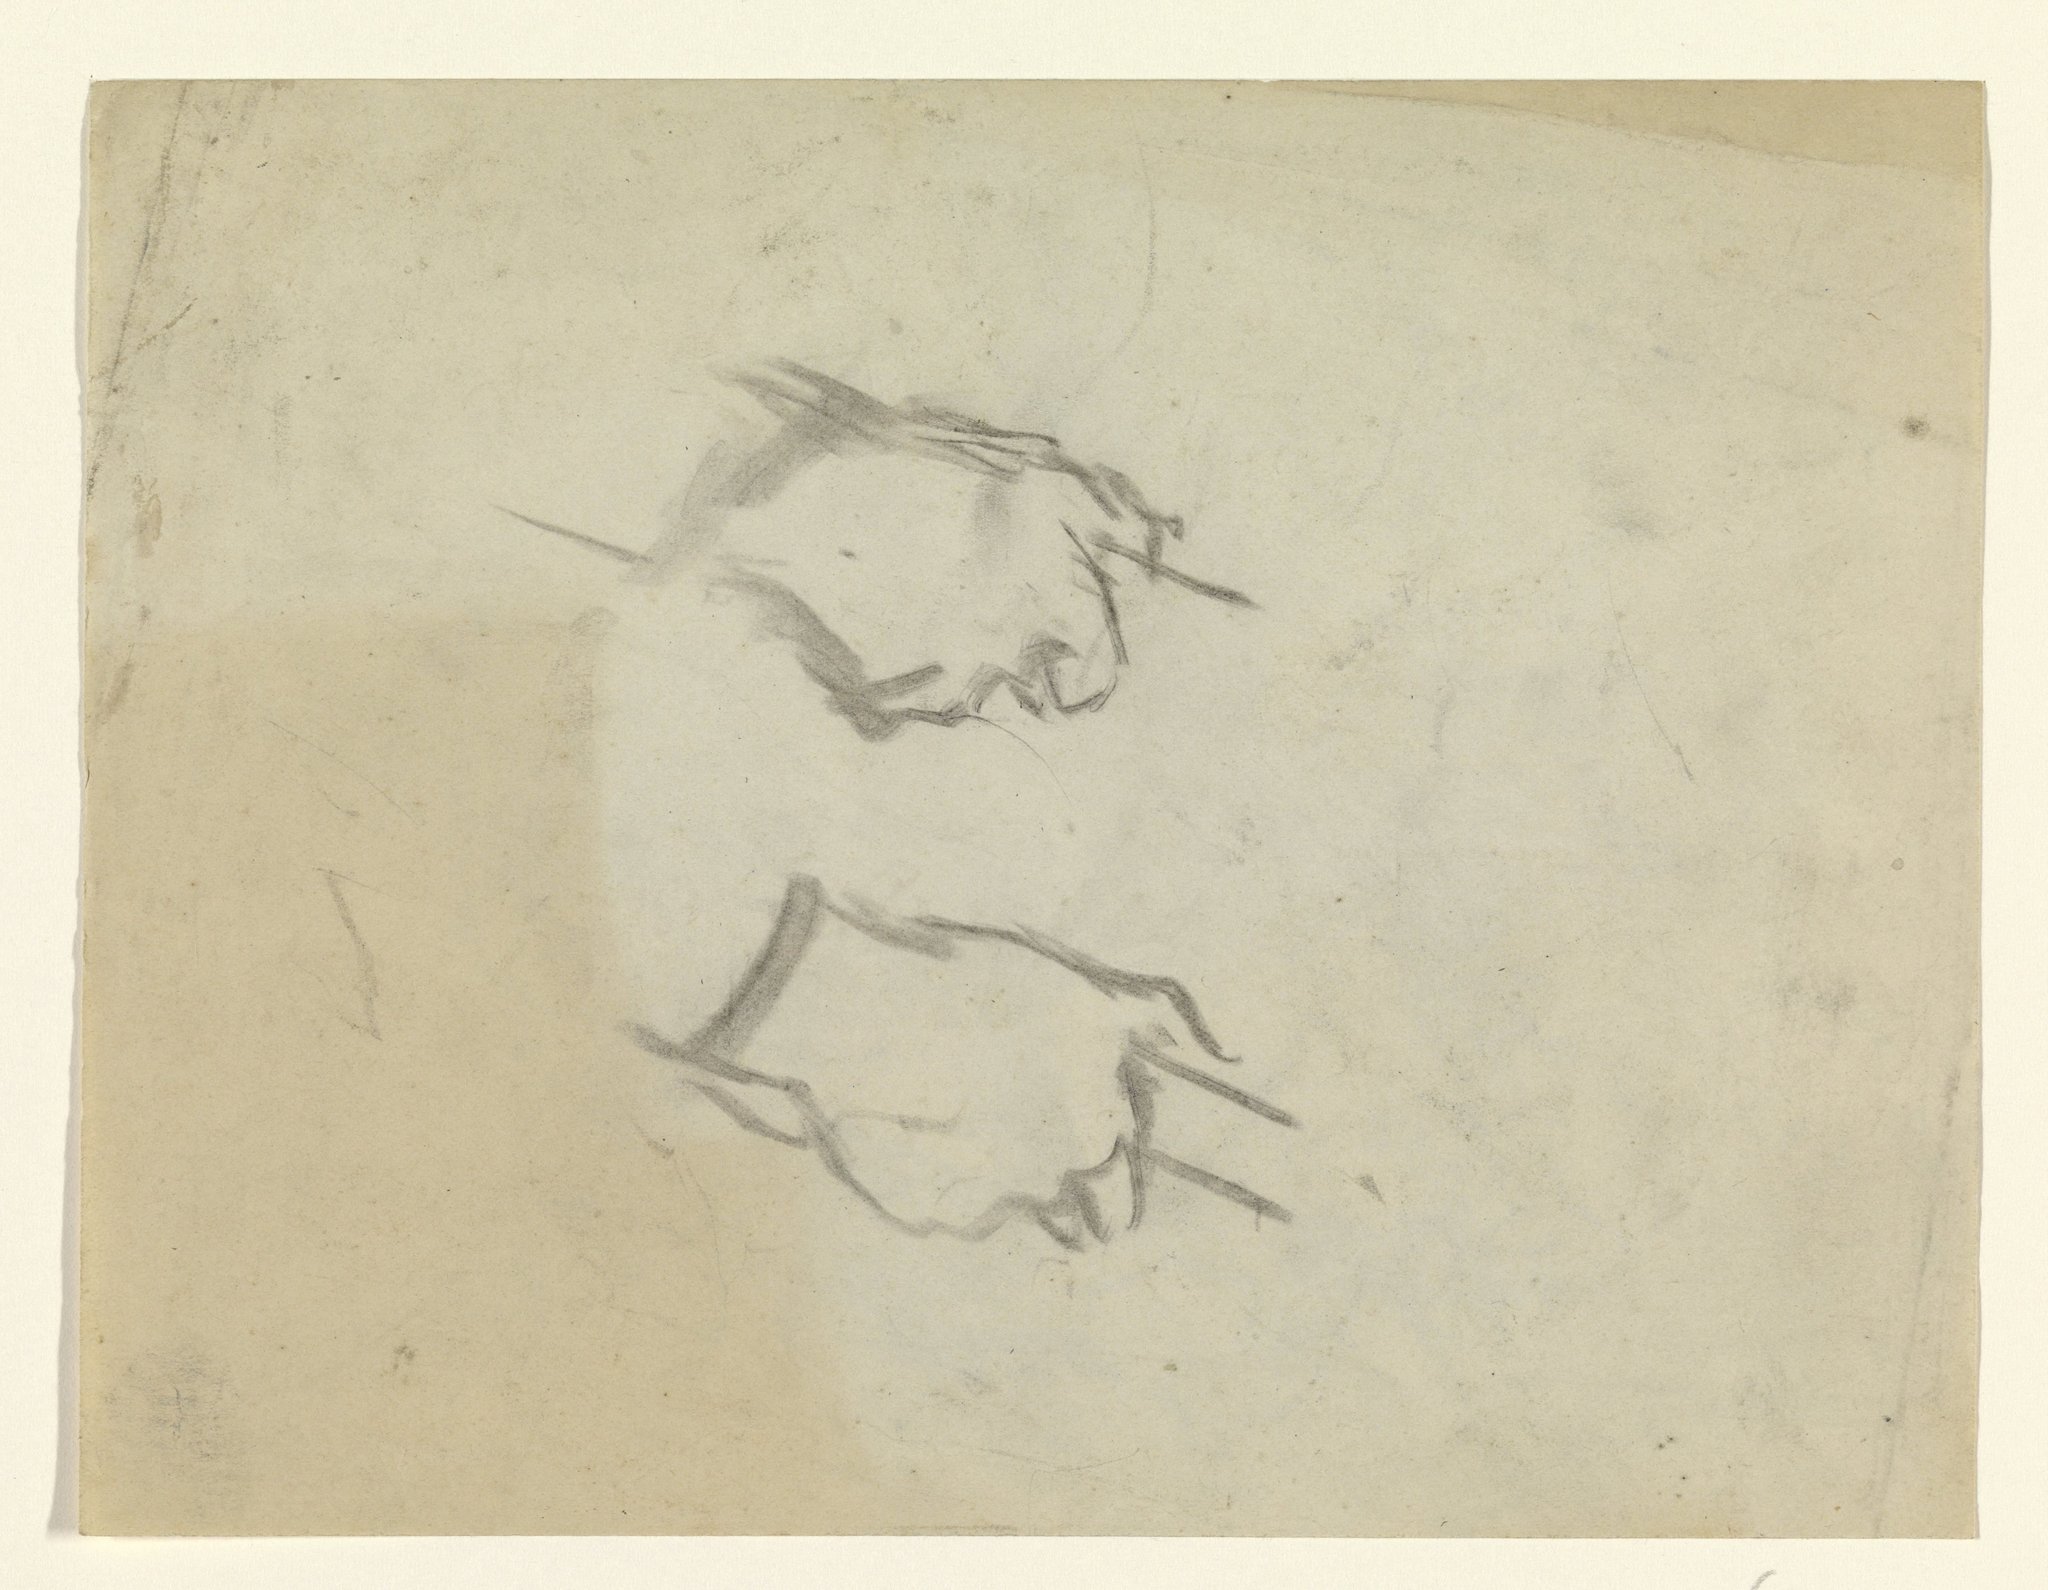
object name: drawing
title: Twee handen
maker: leo gestel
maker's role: draughtsman, print maker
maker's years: 1881-1941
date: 1891-1941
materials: chalk, paper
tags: hand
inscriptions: collector's mark: Lugt 2228